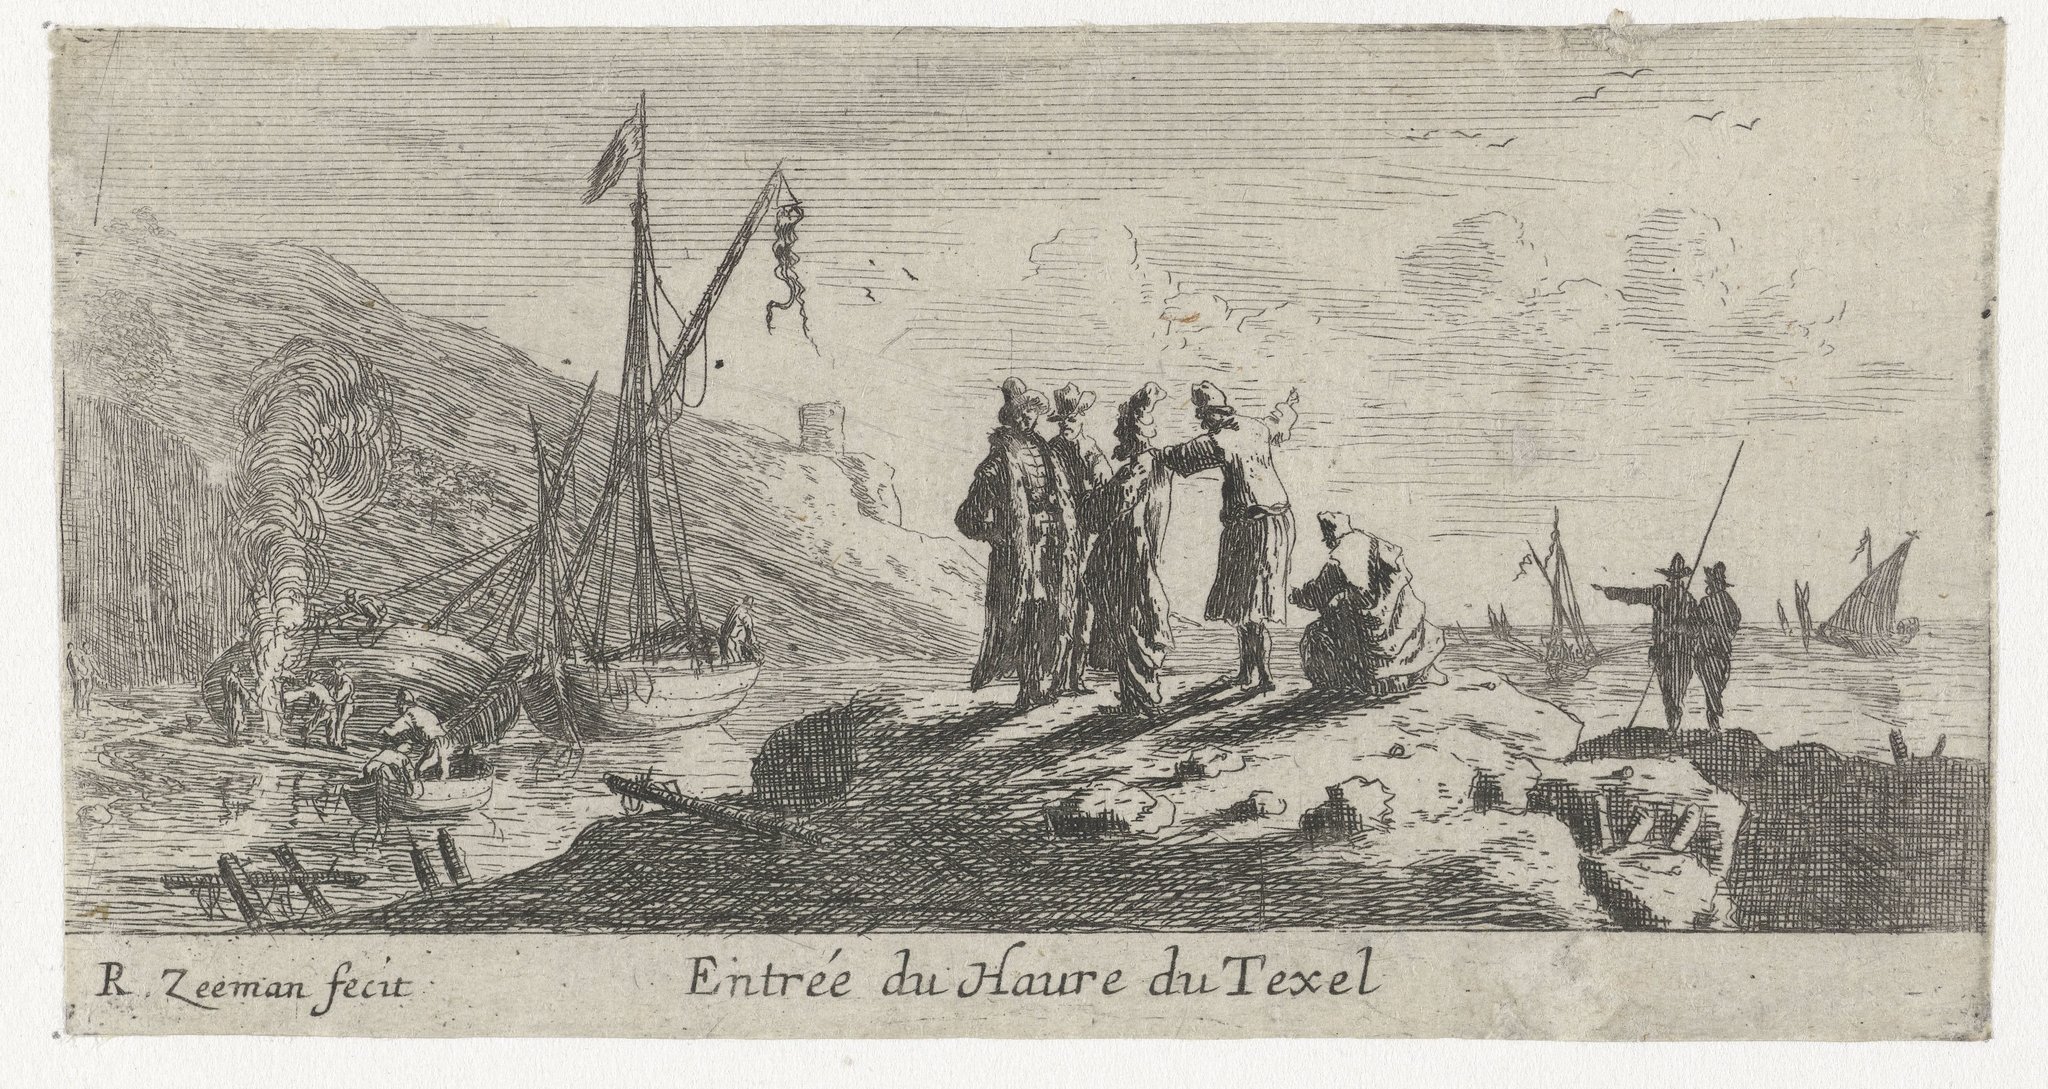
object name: print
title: Receüil de plusiers Navires, et Païsages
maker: reinier nooms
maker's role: draughtsman, painter, print maker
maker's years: 1623-1664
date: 1650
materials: paper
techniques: etching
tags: harbour, repairing, caulking, careening (~ ship)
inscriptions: collector's mark: Lugt 240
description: De ingang van de rede, een natuurlijke ankerplaats voor schepen, bij Texel. In het water wordt een schip gerepareerd, op de wal staat een groep mannen.